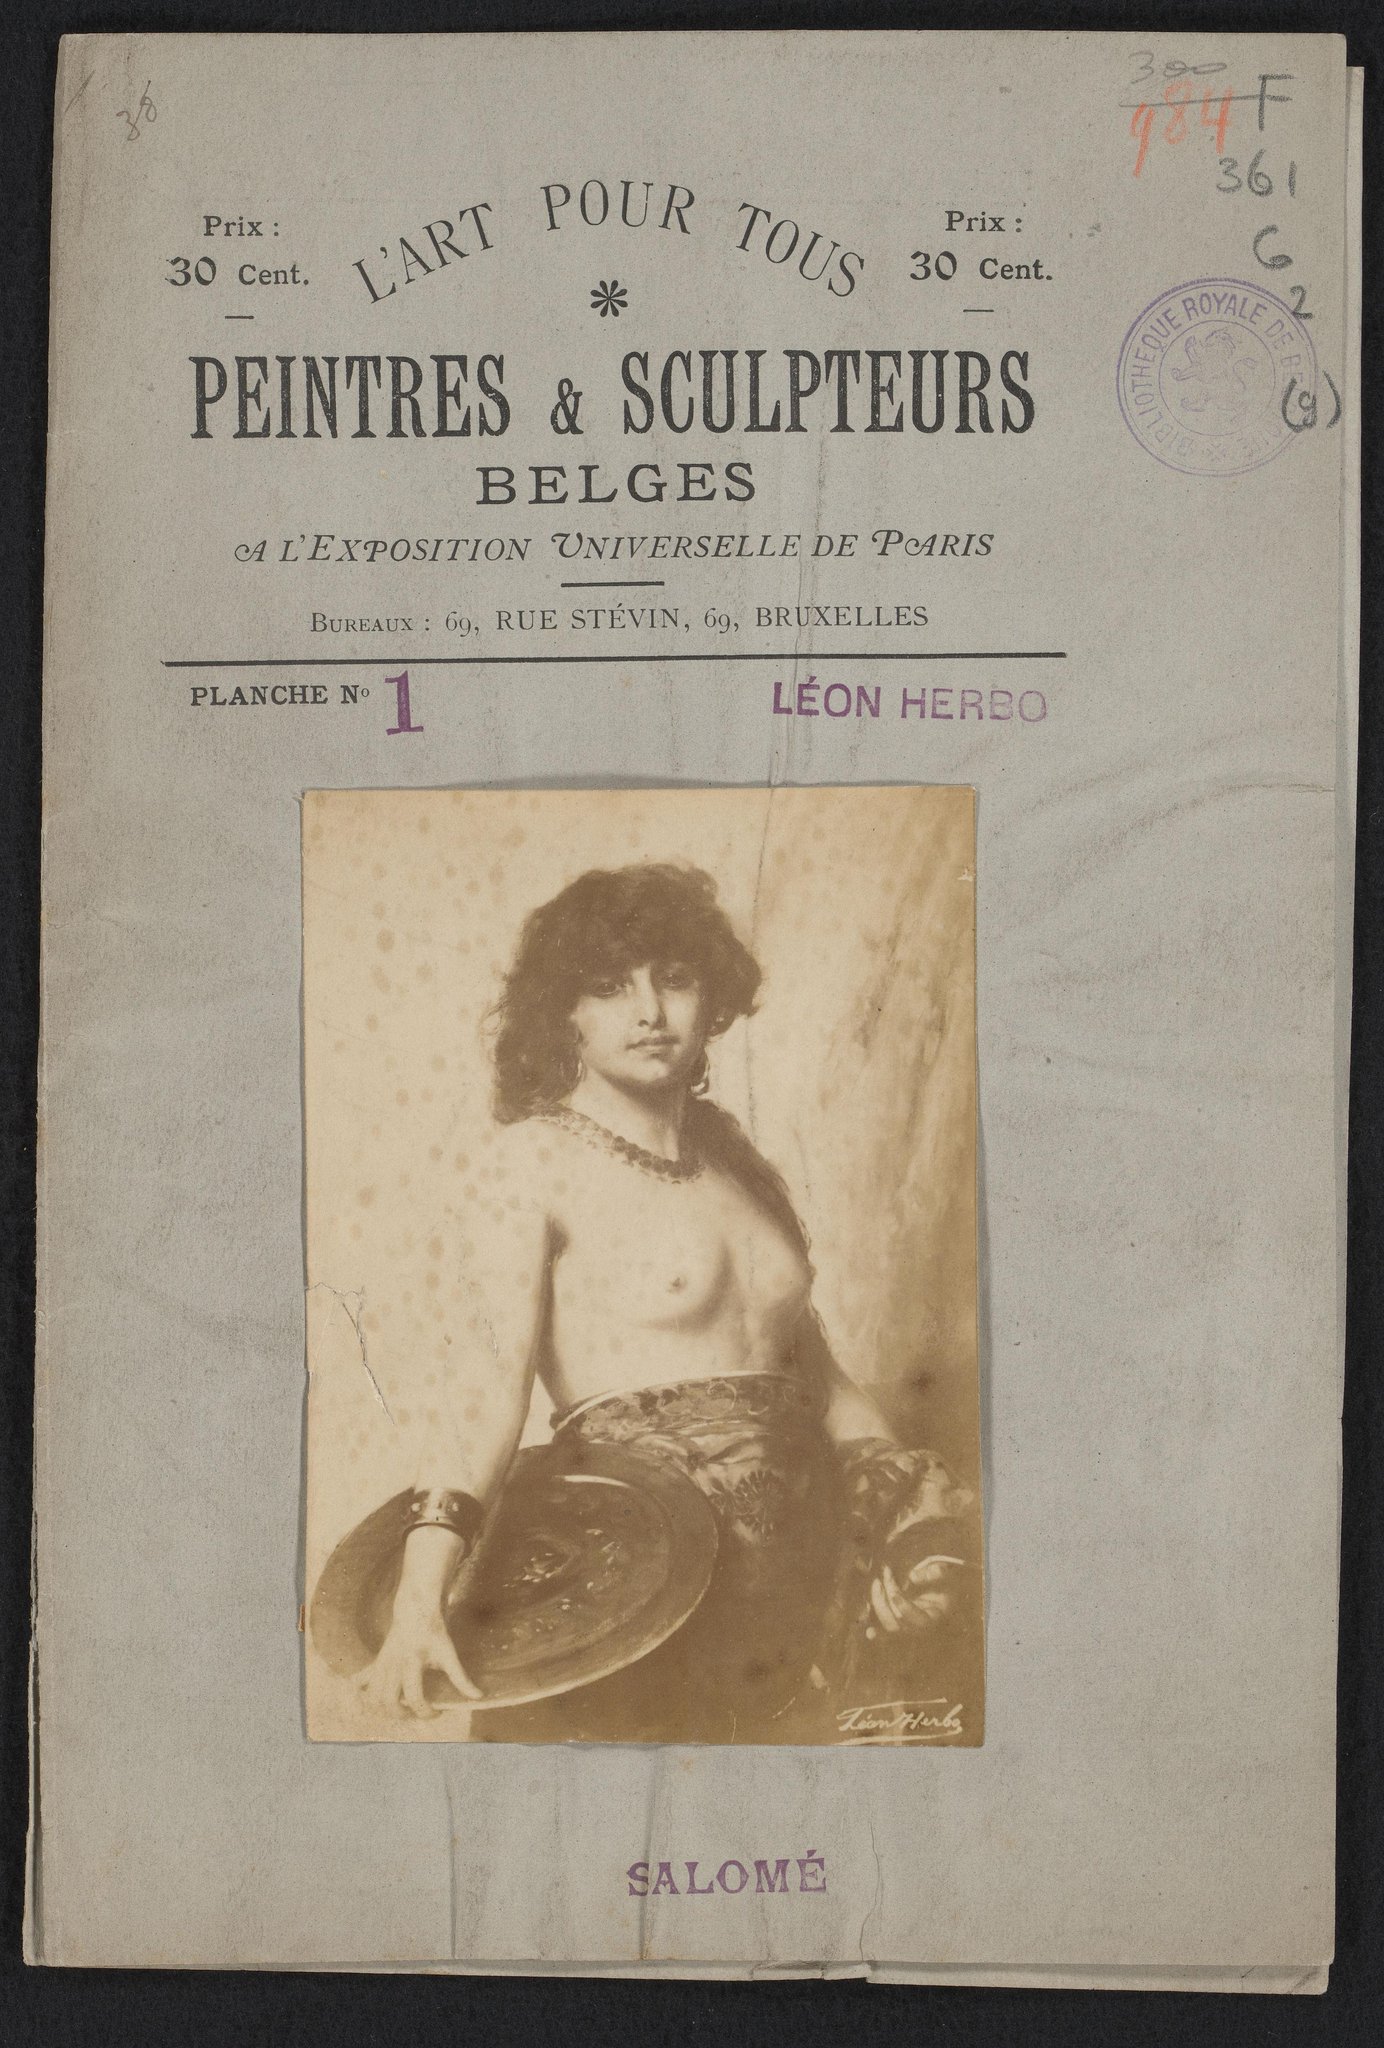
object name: book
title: L'art pour tous : peintres et sculpteurs belges à l'Exposition universelle de Paris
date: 1889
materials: paper, photographic support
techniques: albumen print, printing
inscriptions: collector's mark: ‘Bibliotheque Royale de Belgique’, number: ‘38/ 300/ 984’